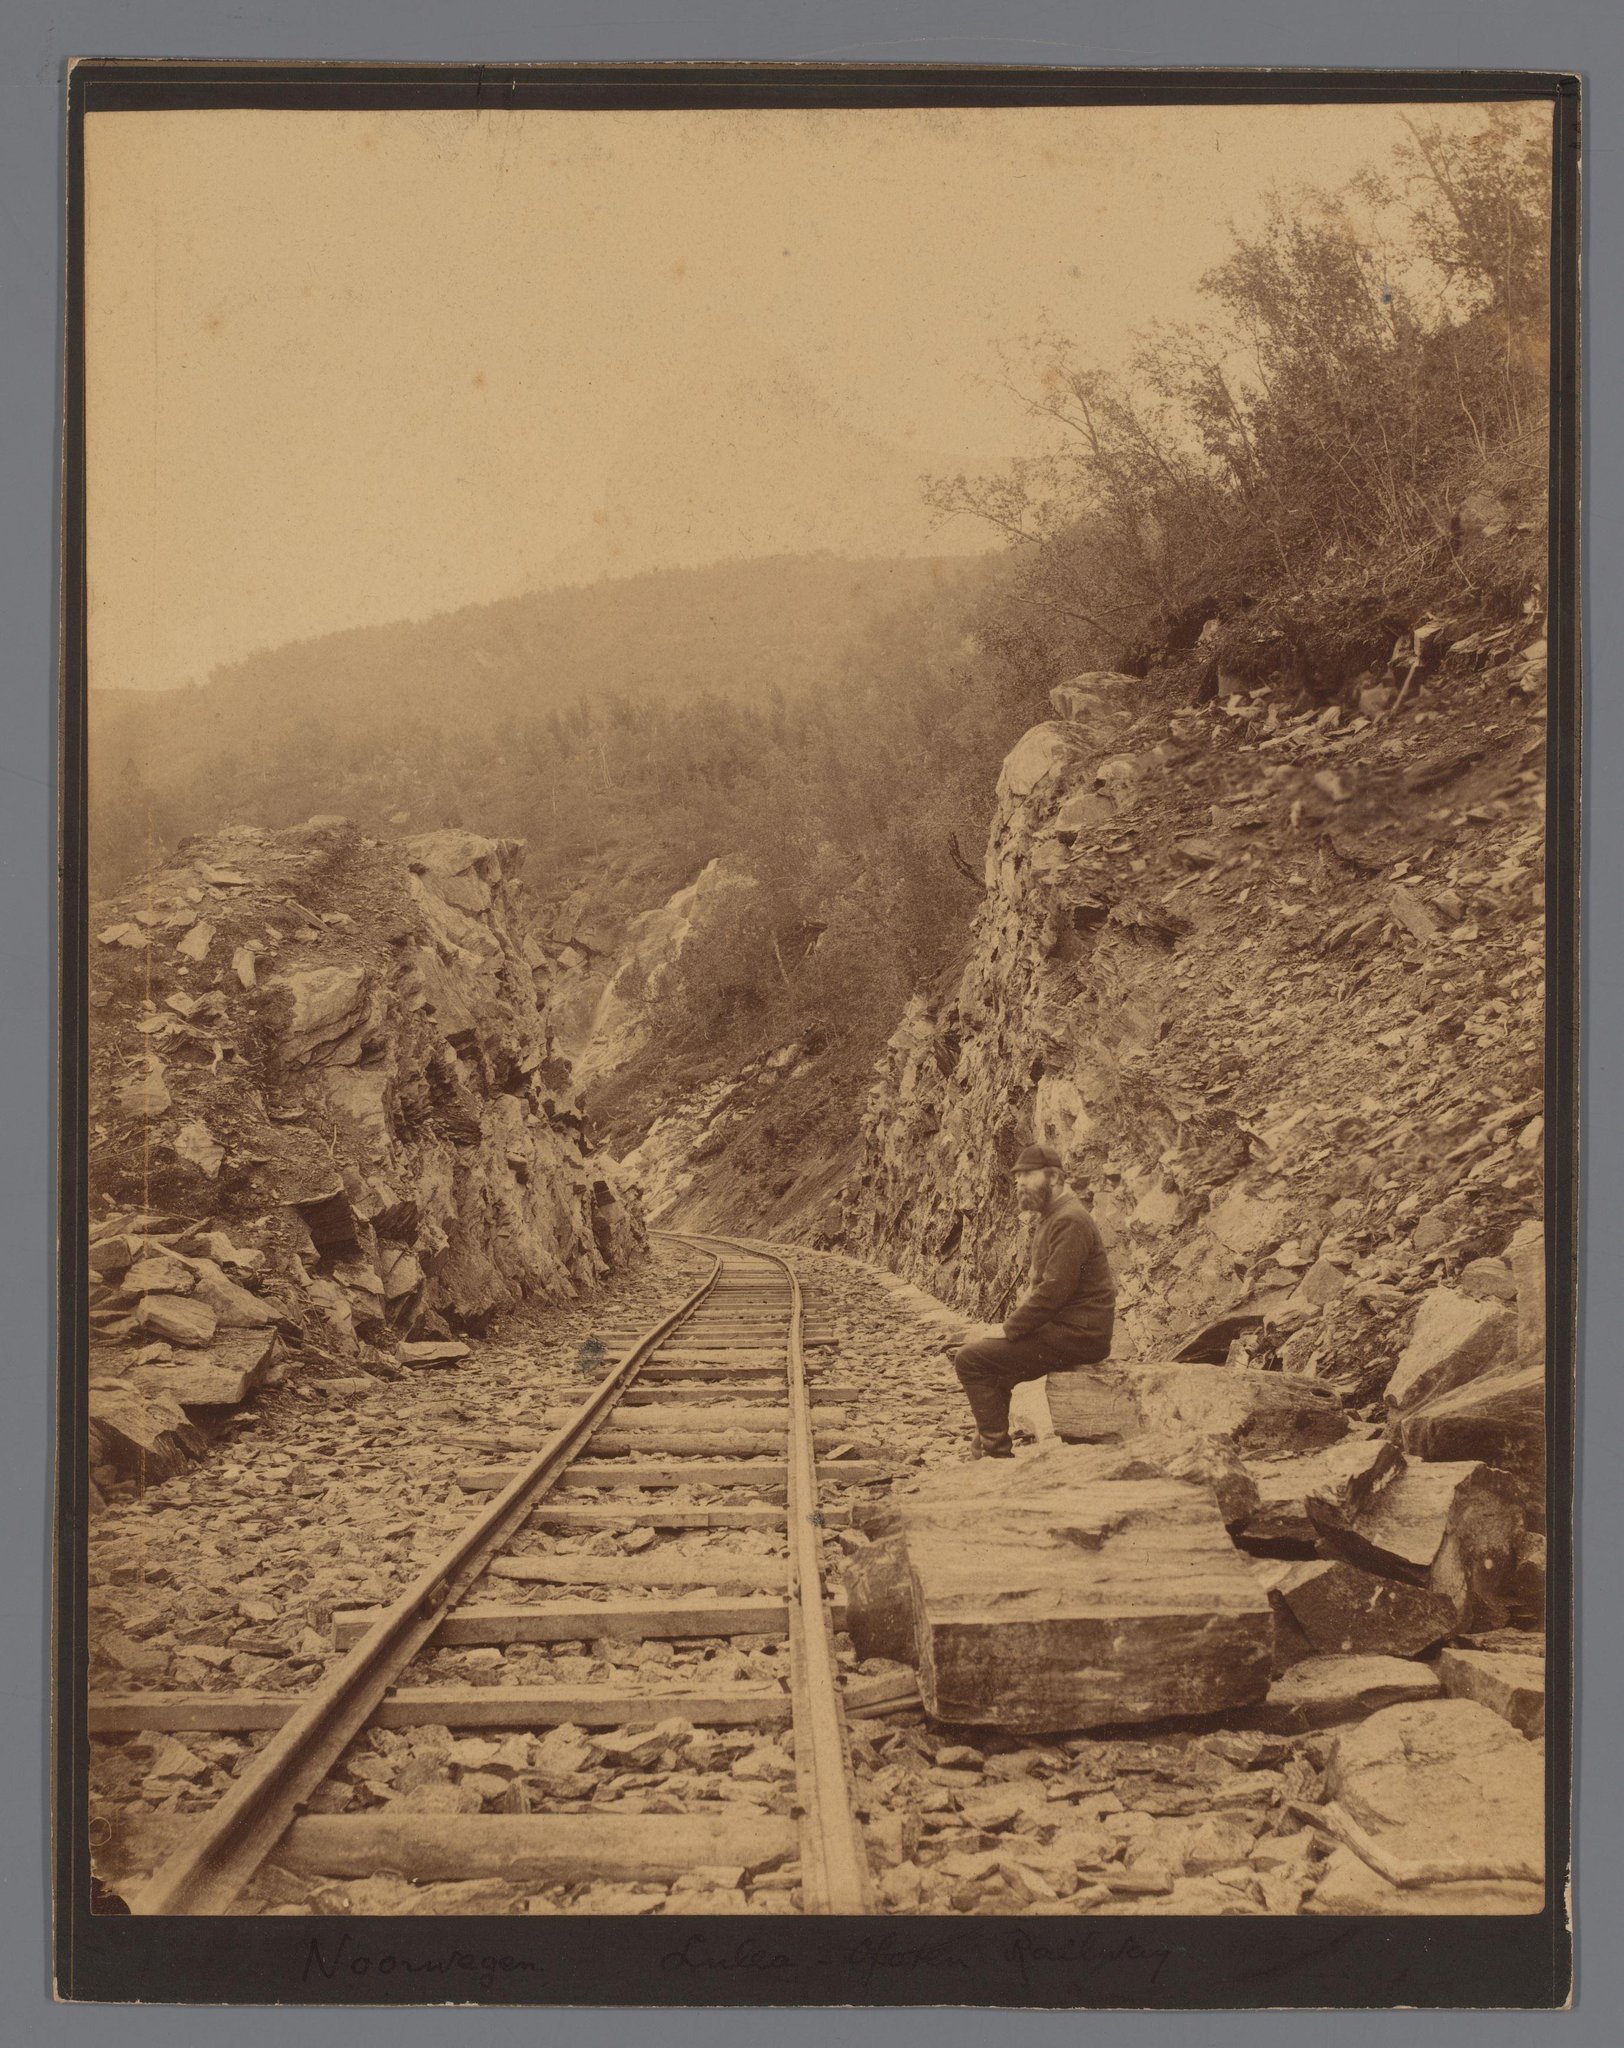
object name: photograph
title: Noorwegen, Lulea - Ofoten railway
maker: Anonymous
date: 1888-1900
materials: cardboard, paper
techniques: albumen print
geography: sweden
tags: railway, train